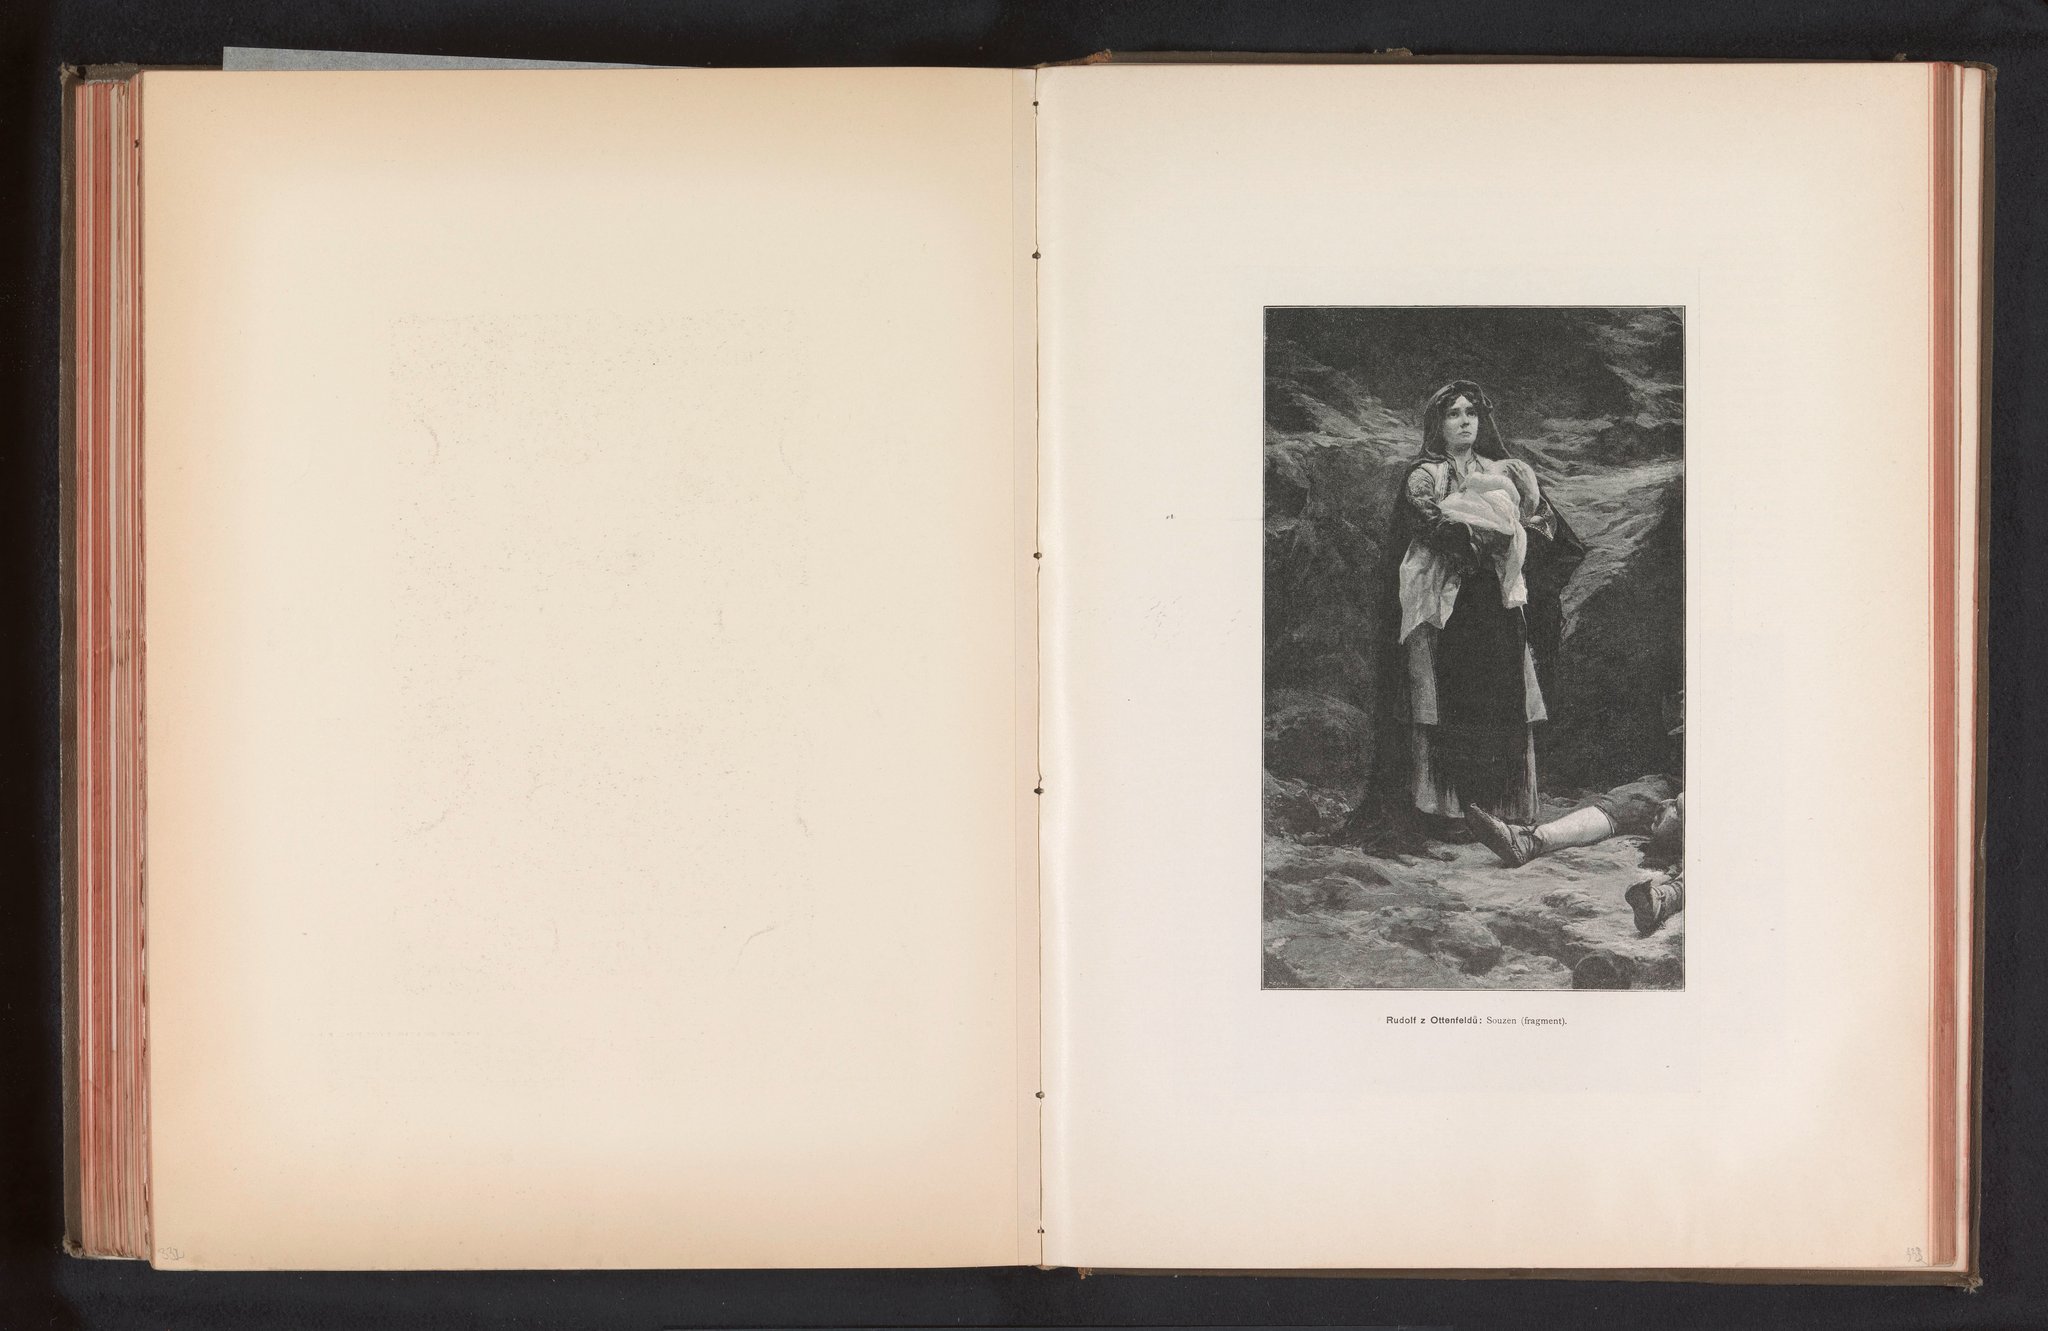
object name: page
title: Rudolf z Ottenfeldu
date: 1891-1895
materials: paper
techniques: photograph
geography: prague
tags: mother and baby or young child